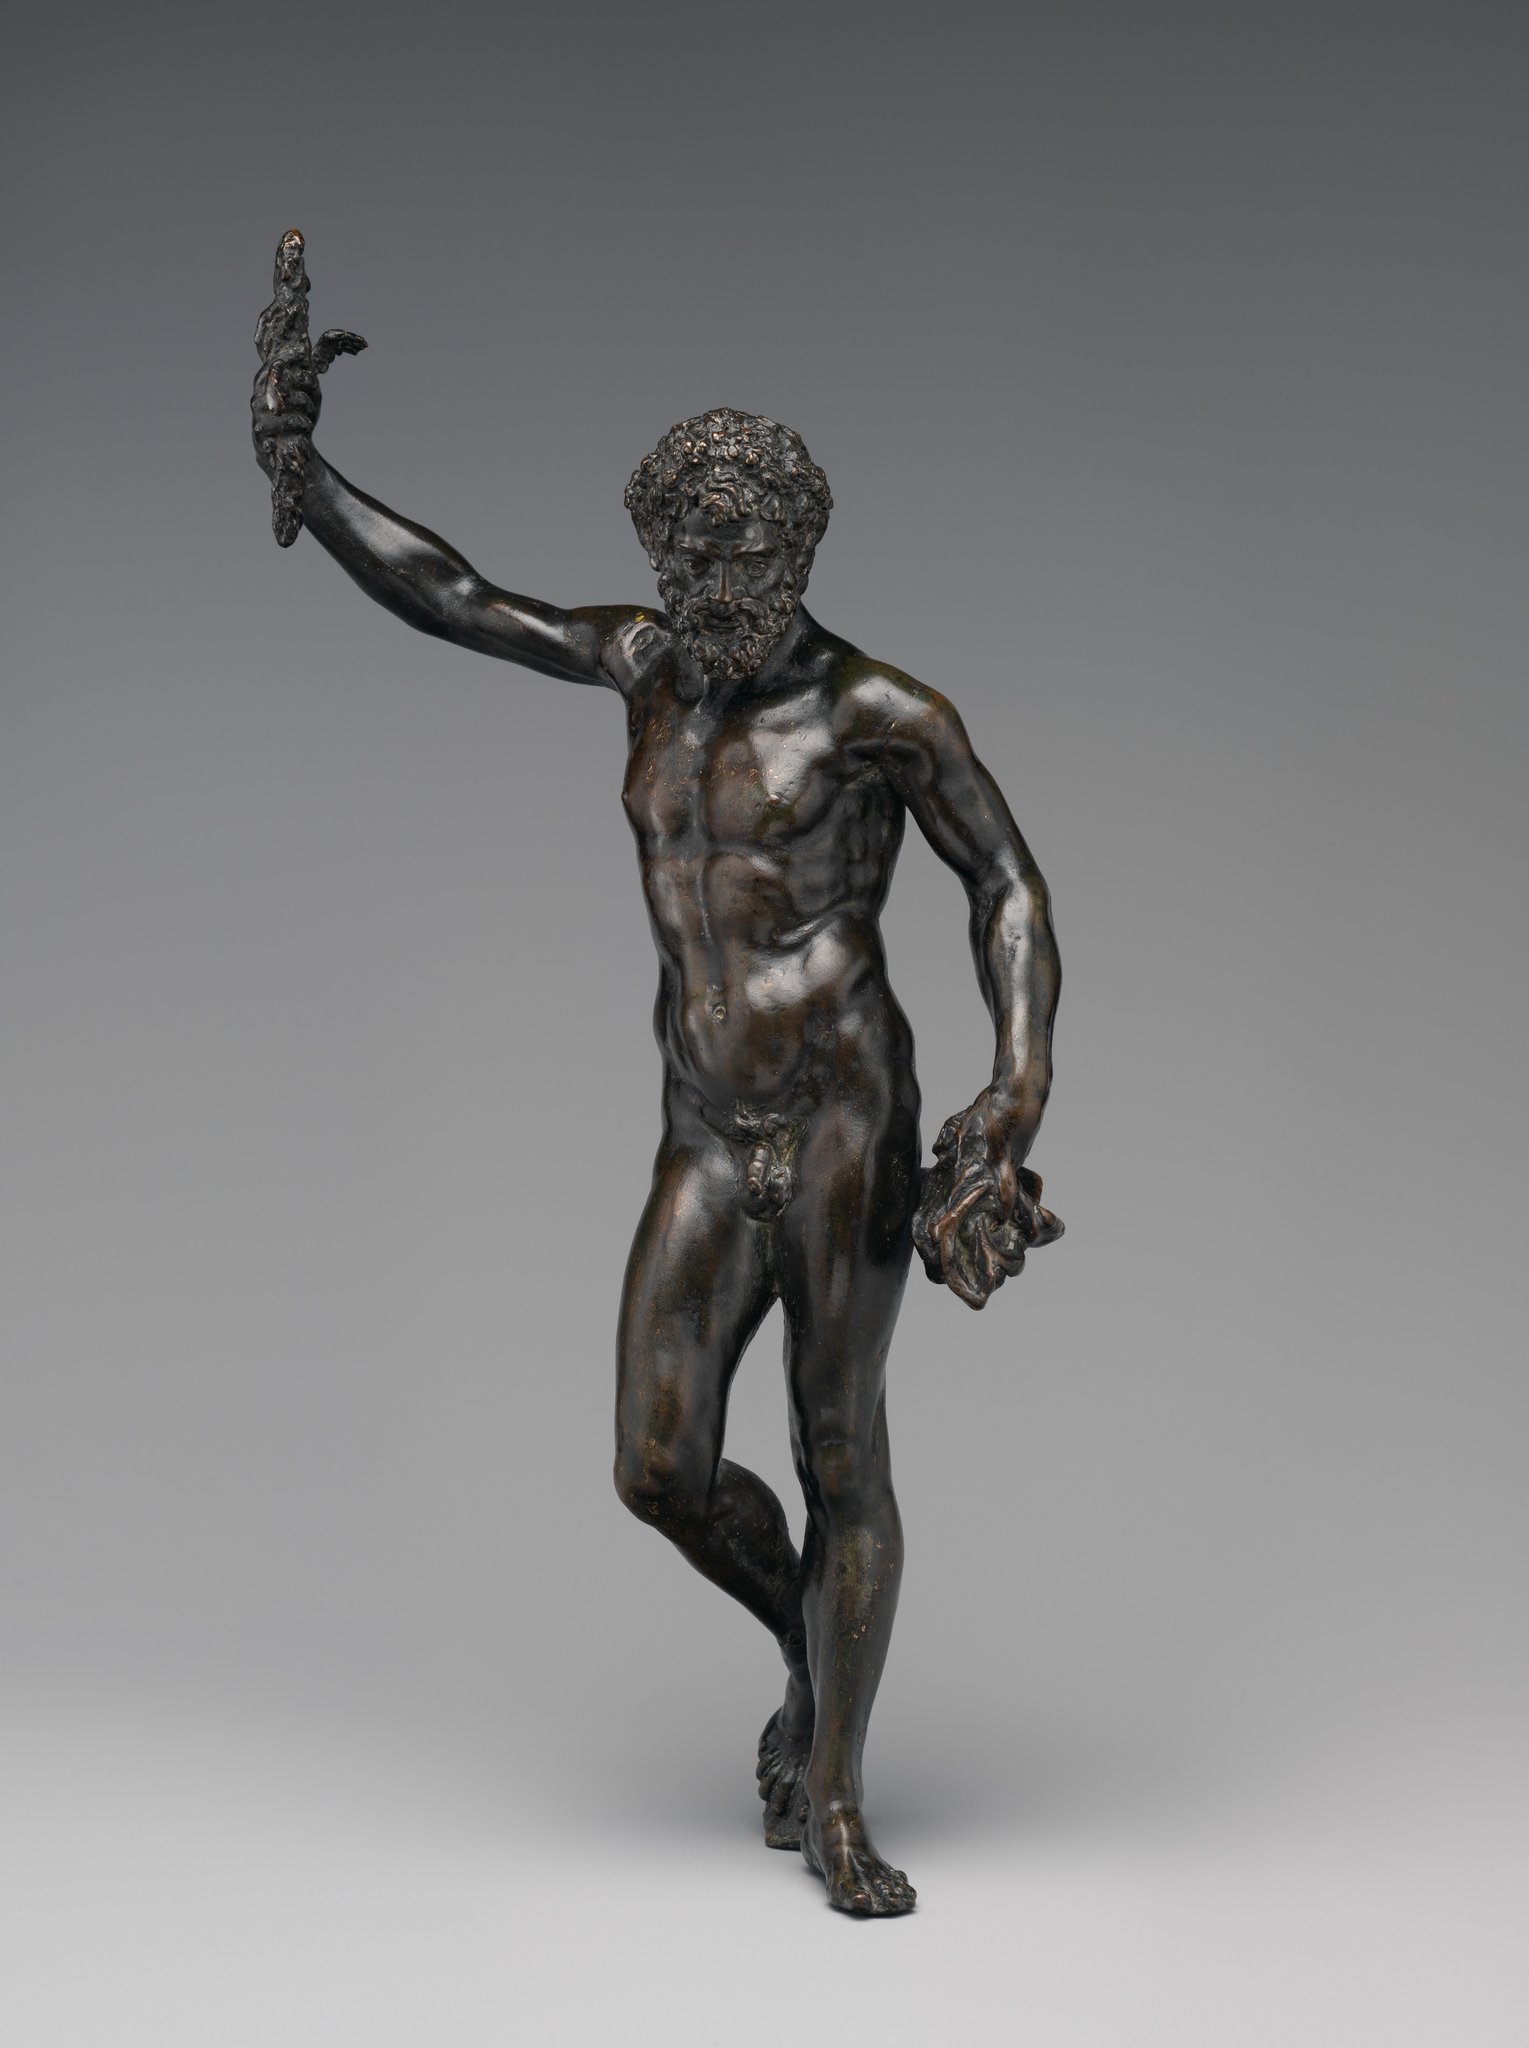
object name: statuette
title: Jupiter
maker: benvenuto cellini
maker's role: modeler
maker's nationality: italian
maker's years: 1500-1571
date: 1567-1600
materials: bronze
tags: jupiter